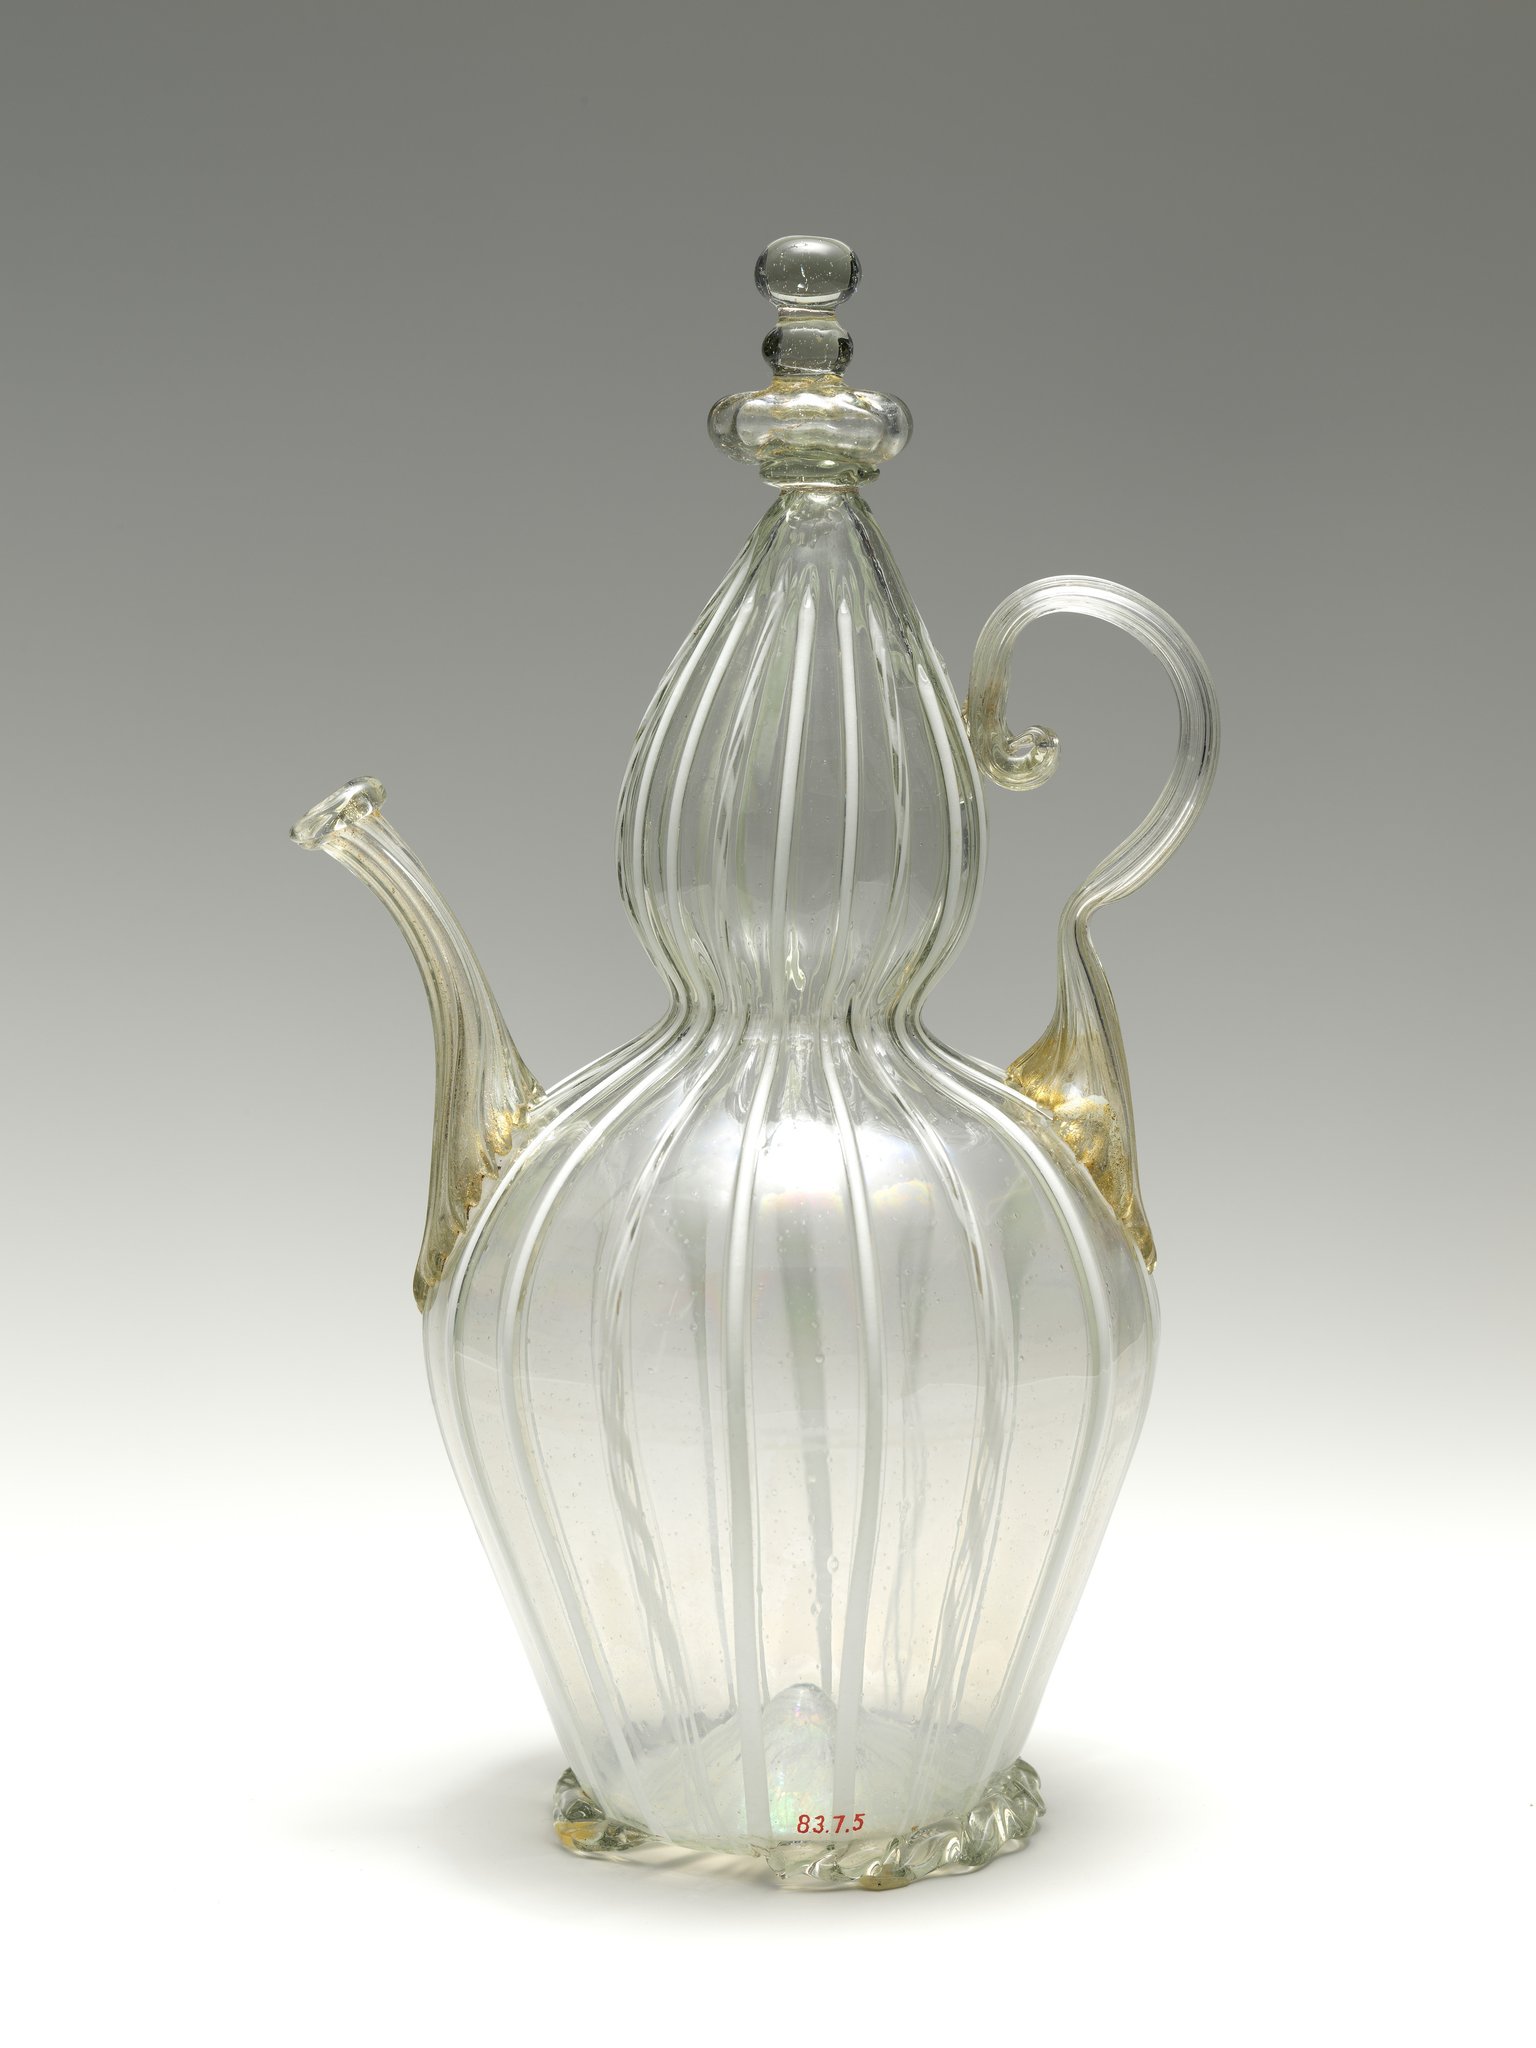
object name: cruet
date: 1701-1900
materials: glass